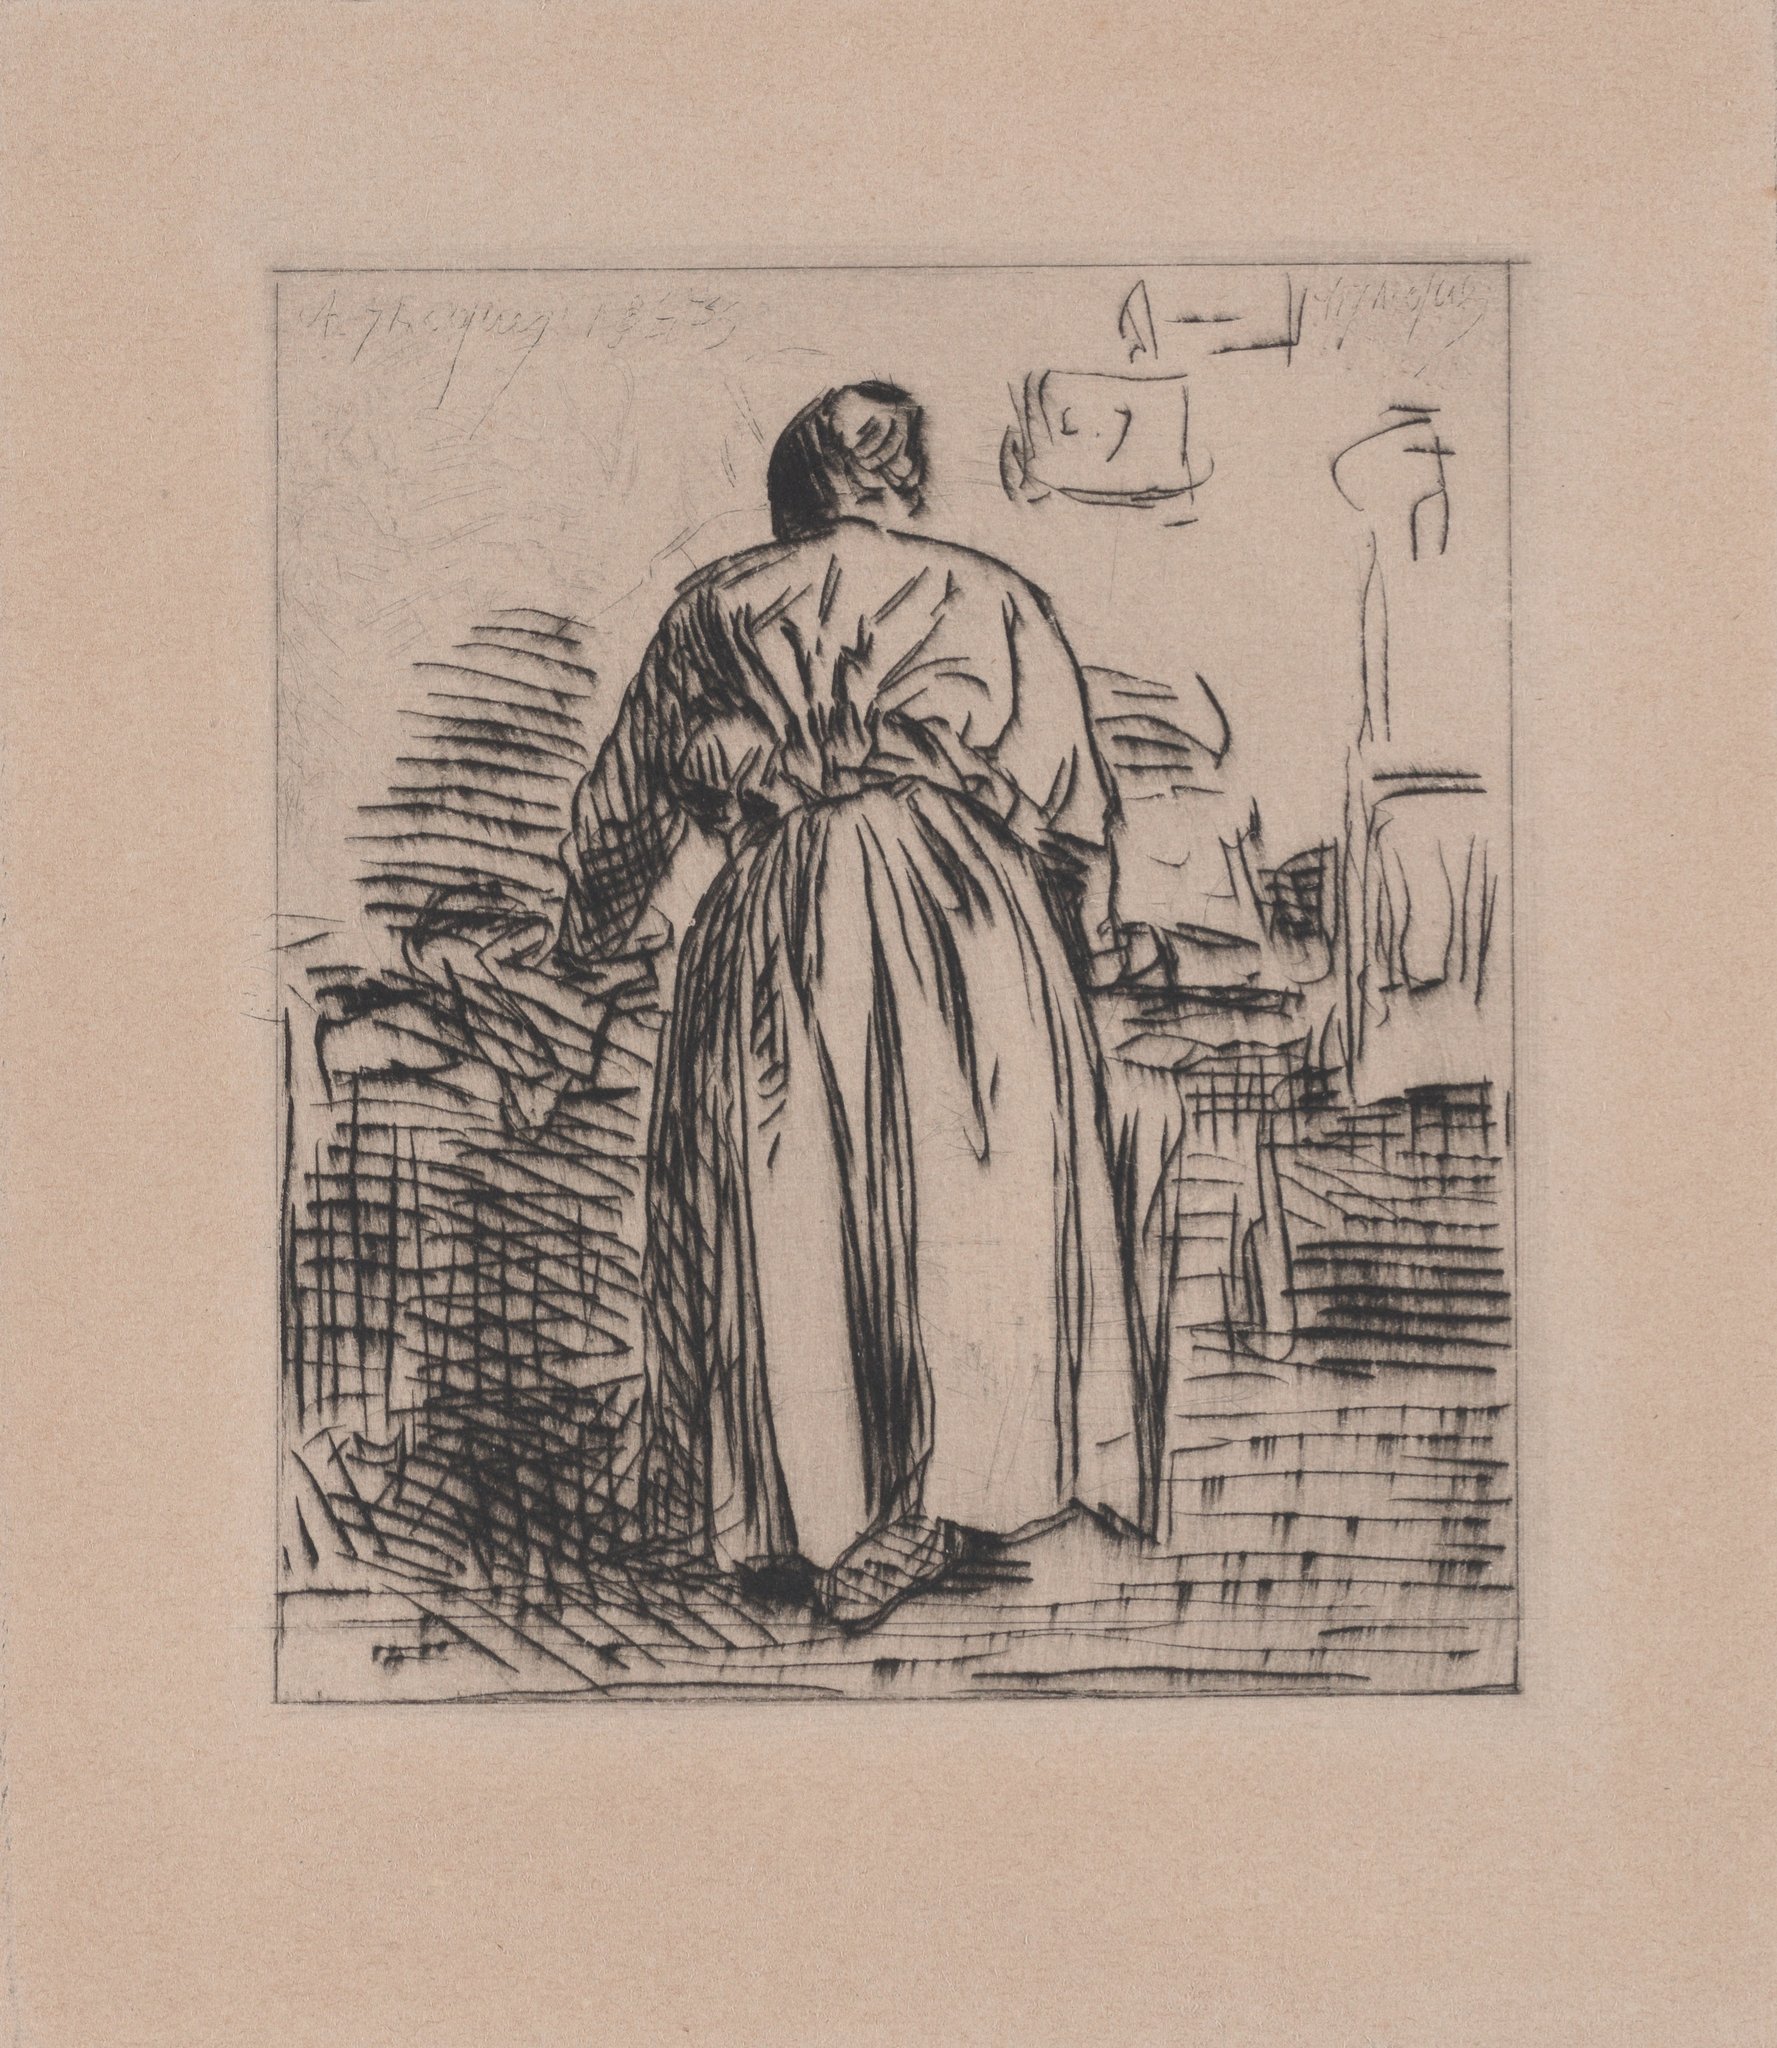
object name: print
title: The Ironing Woman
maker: charles émile jacque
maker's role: artist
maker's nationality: french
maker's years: 1813-1894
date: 1843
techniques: drypoint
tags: women,working